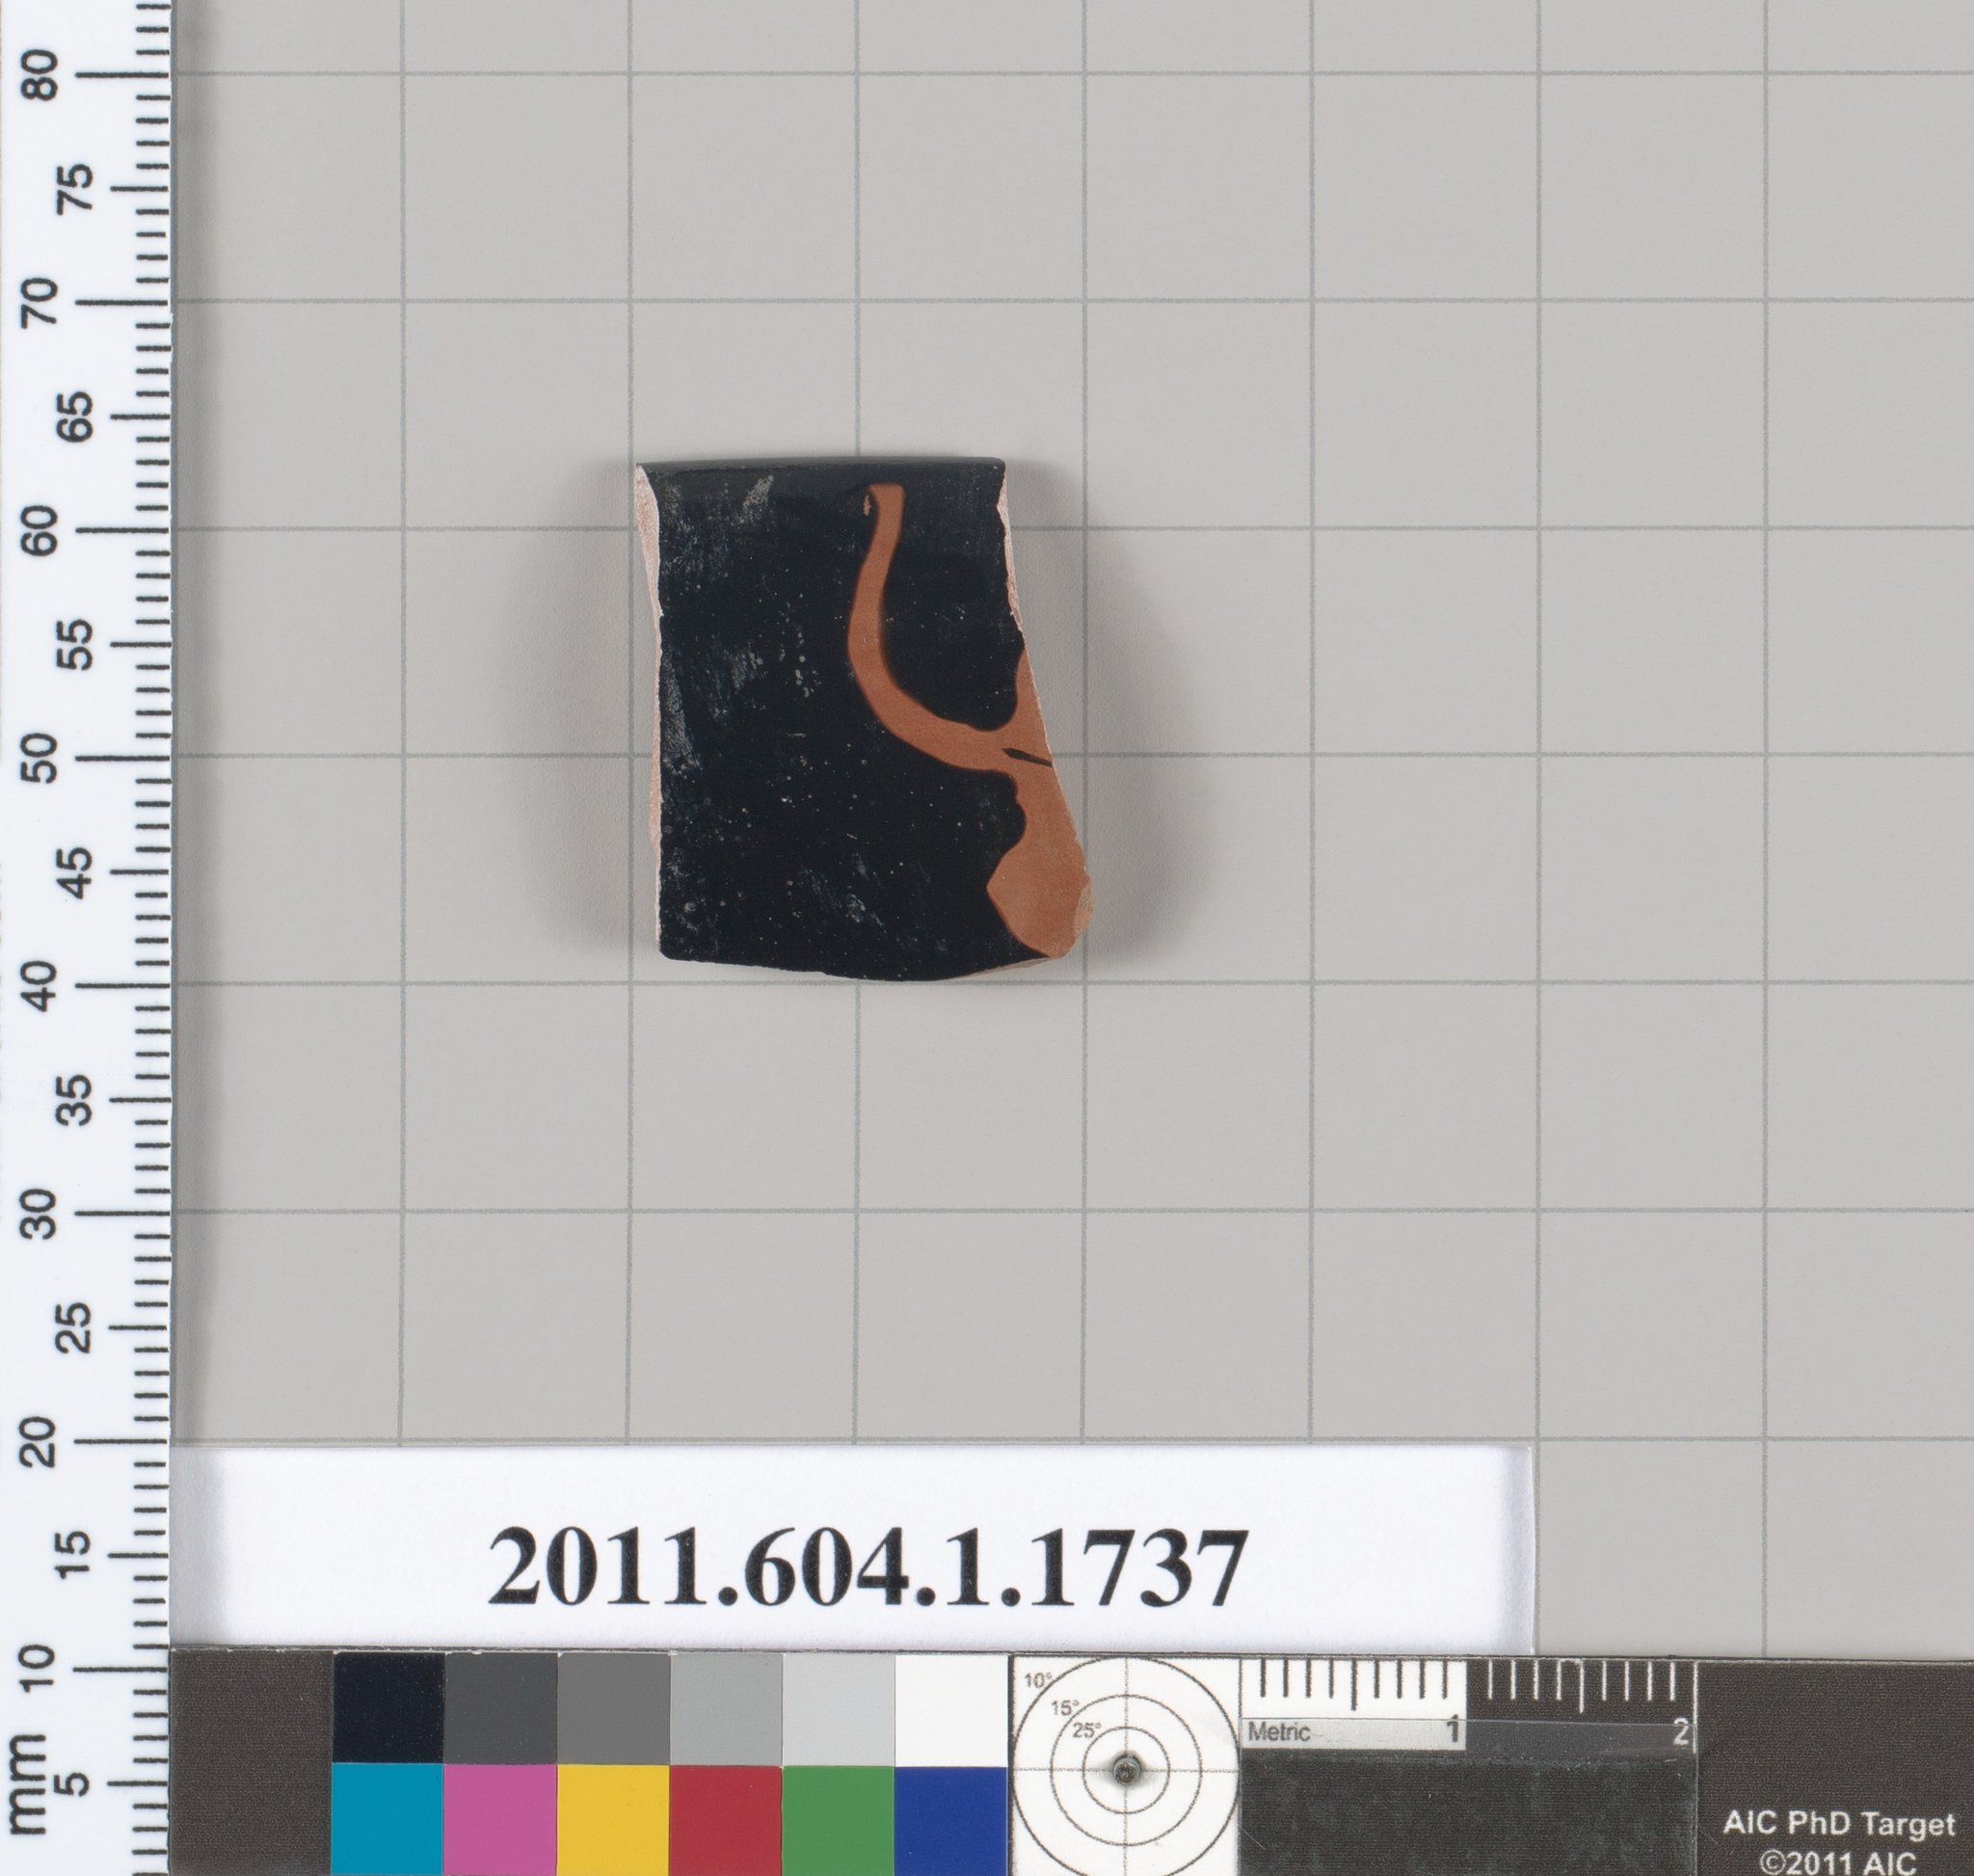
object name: kylix fragment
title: Terracotta rim fragment of a kylix (drinking cup)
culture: greek, attic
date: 475-451 BCE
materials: terracotta